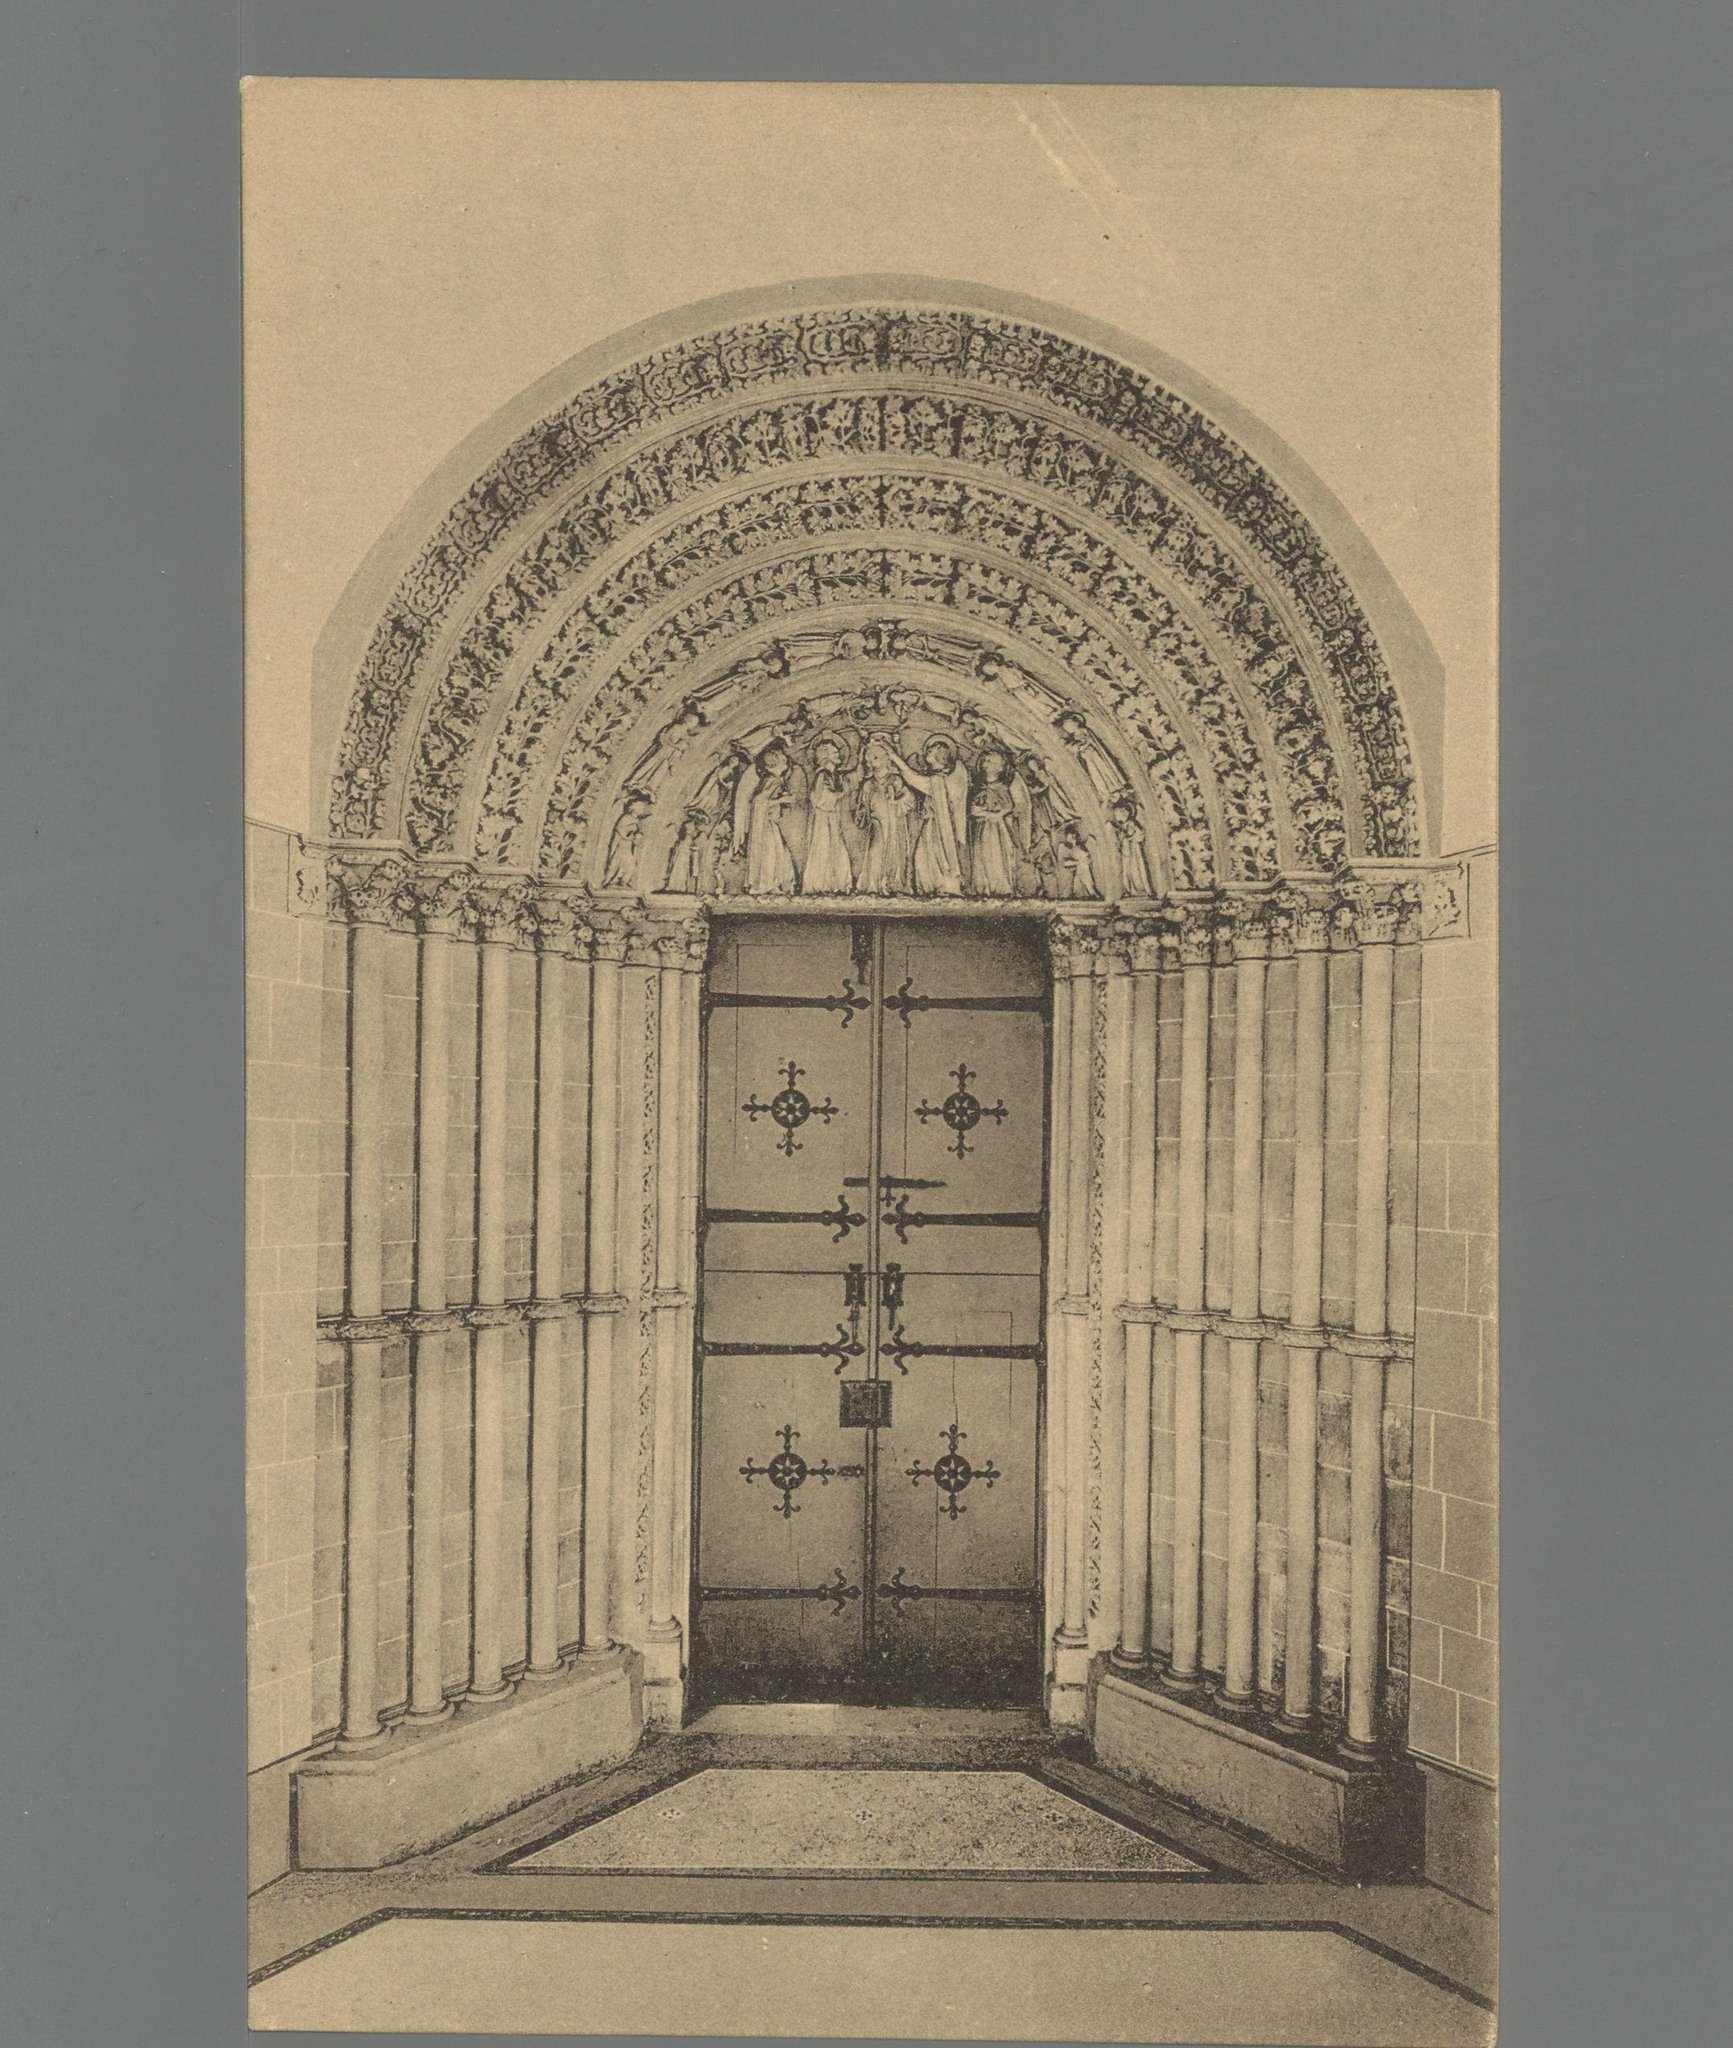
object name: ansichtkaart, prentbriefkaart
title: Trier. Liebfrauenkirche. Nordportal (13. Jahrh.)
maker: Anonymous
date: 1905-1930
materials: cardboard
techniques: photograph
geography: trier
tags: church (exterior), gate, entrance